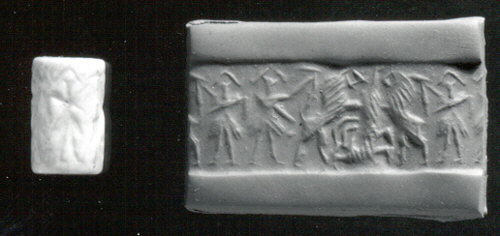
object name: cylinder seal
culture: sumerian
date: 2600-2350 BCE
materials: limestone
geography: mesopotamia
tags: animals